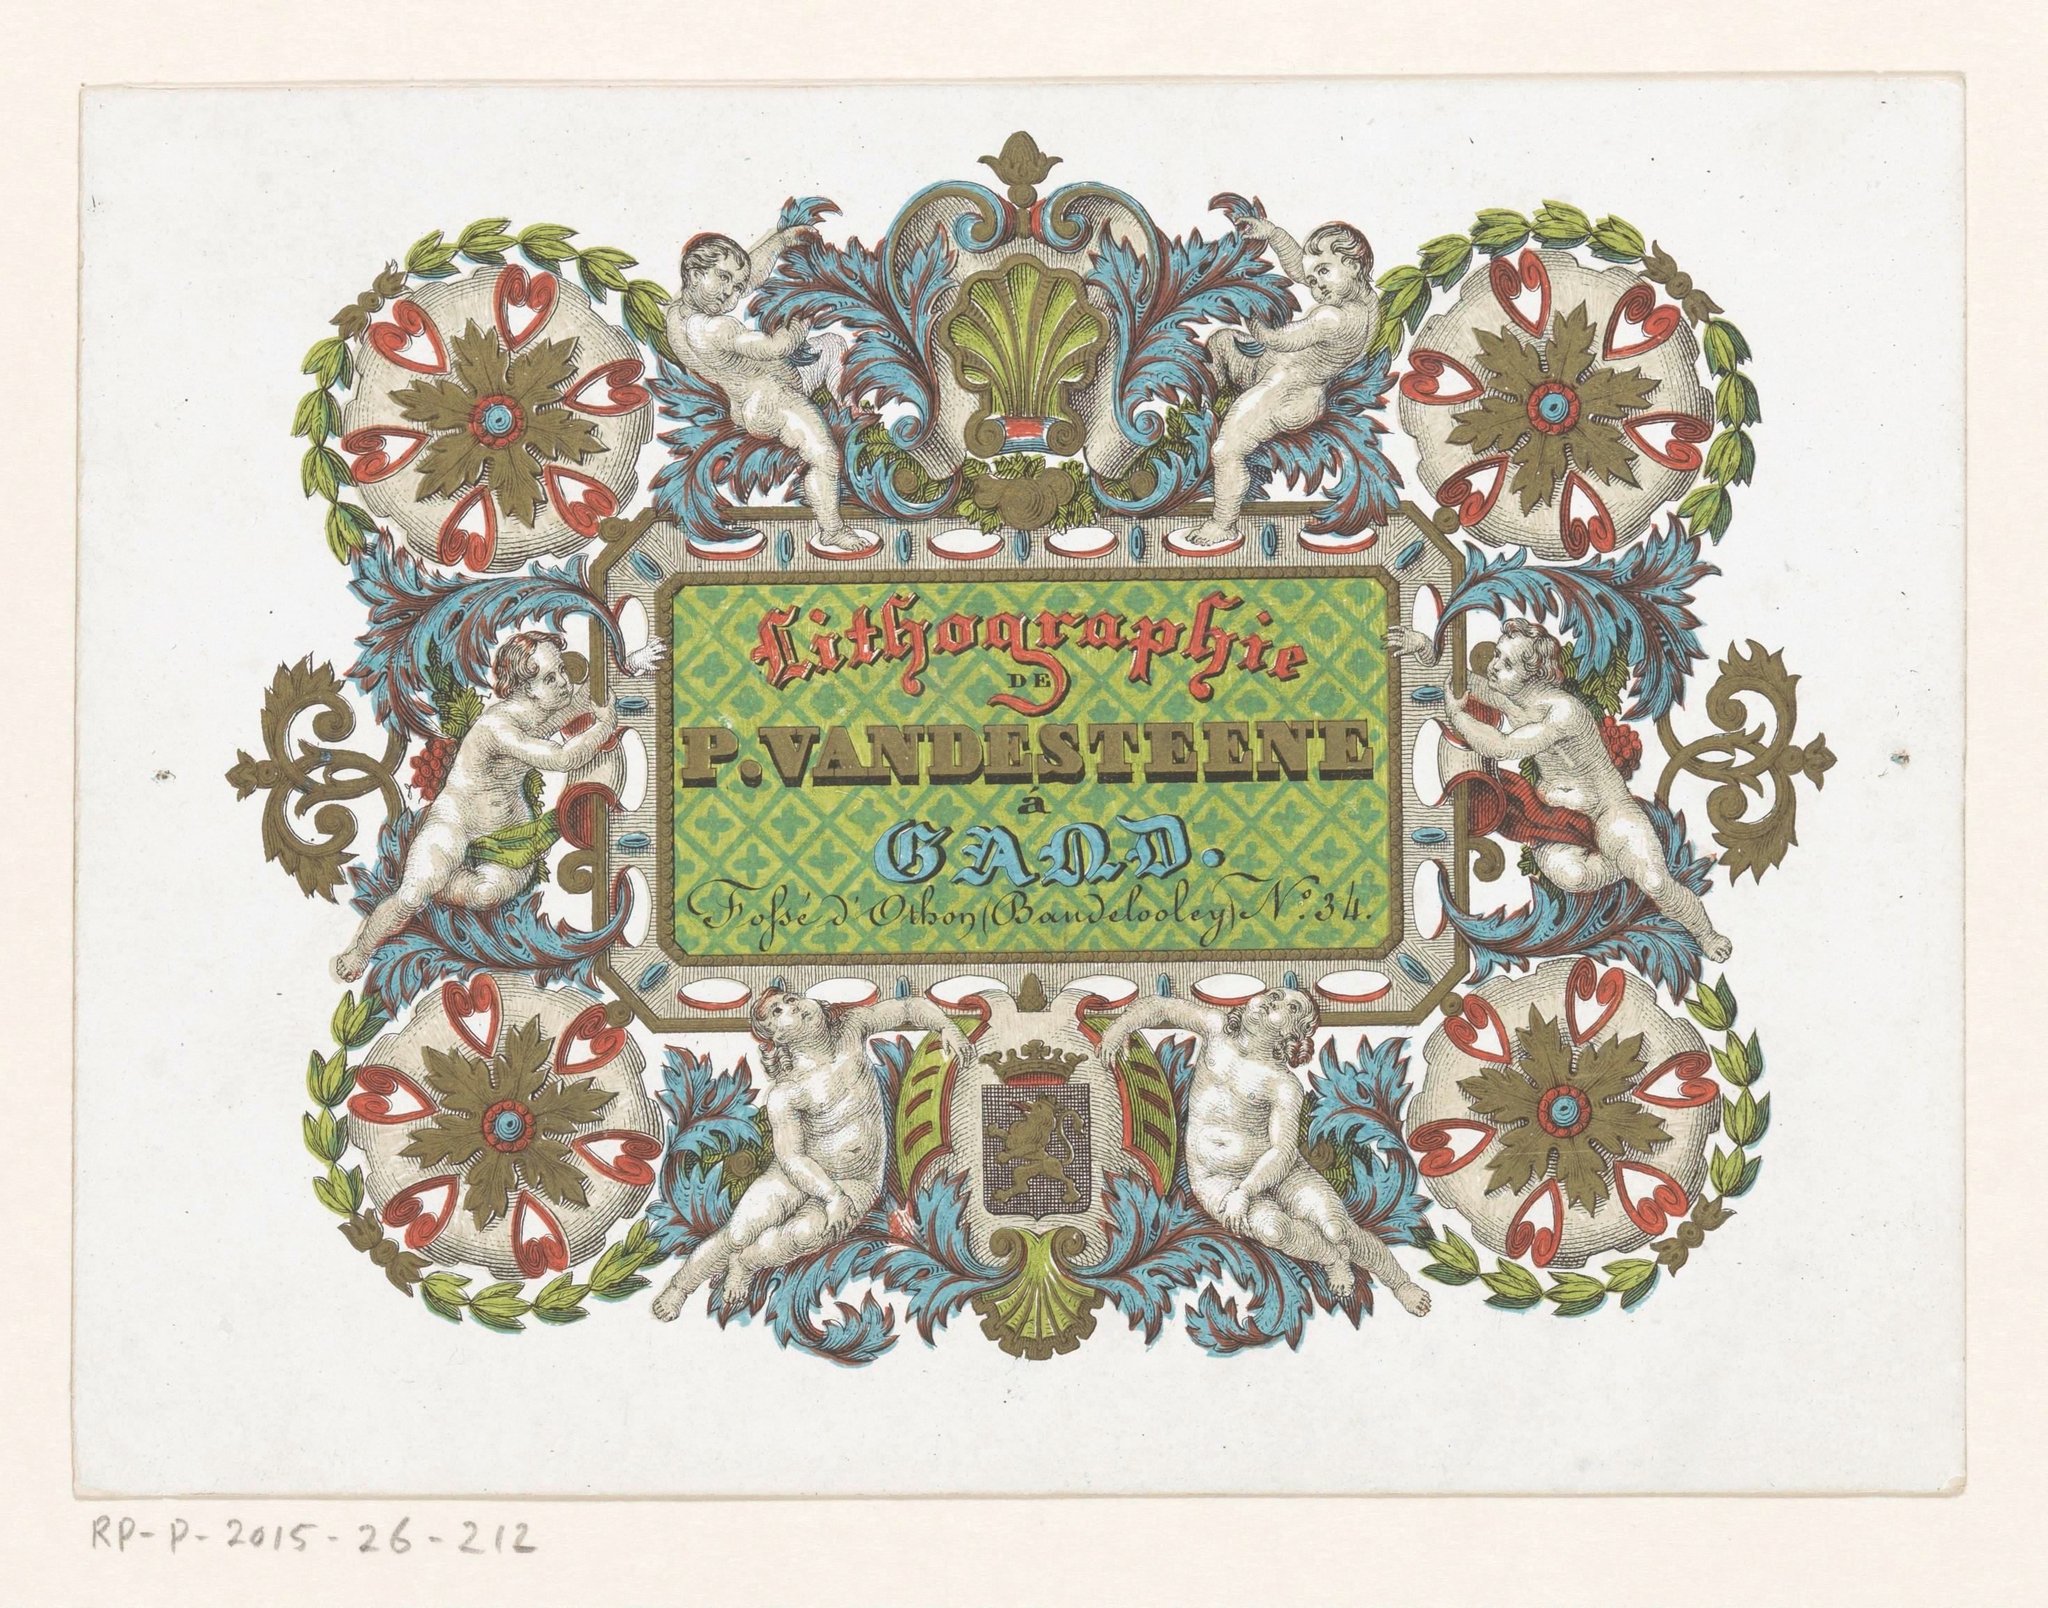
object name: visiting card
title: Visitekaartje van drukkerij Pierre Vande Steene te Gent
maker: pierre vande steene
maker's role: print maker, printer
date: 1841-1874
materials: porcelainized cardboard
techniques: lithograph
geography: ghent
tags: lithographer, cupids: 'amores', 'amoretti', 'putti'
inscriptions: collector's mark: Lugt 4780, collector's mark: Lugt 2228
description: Decoratieve omlijsting met zes putti en het wapen van België.